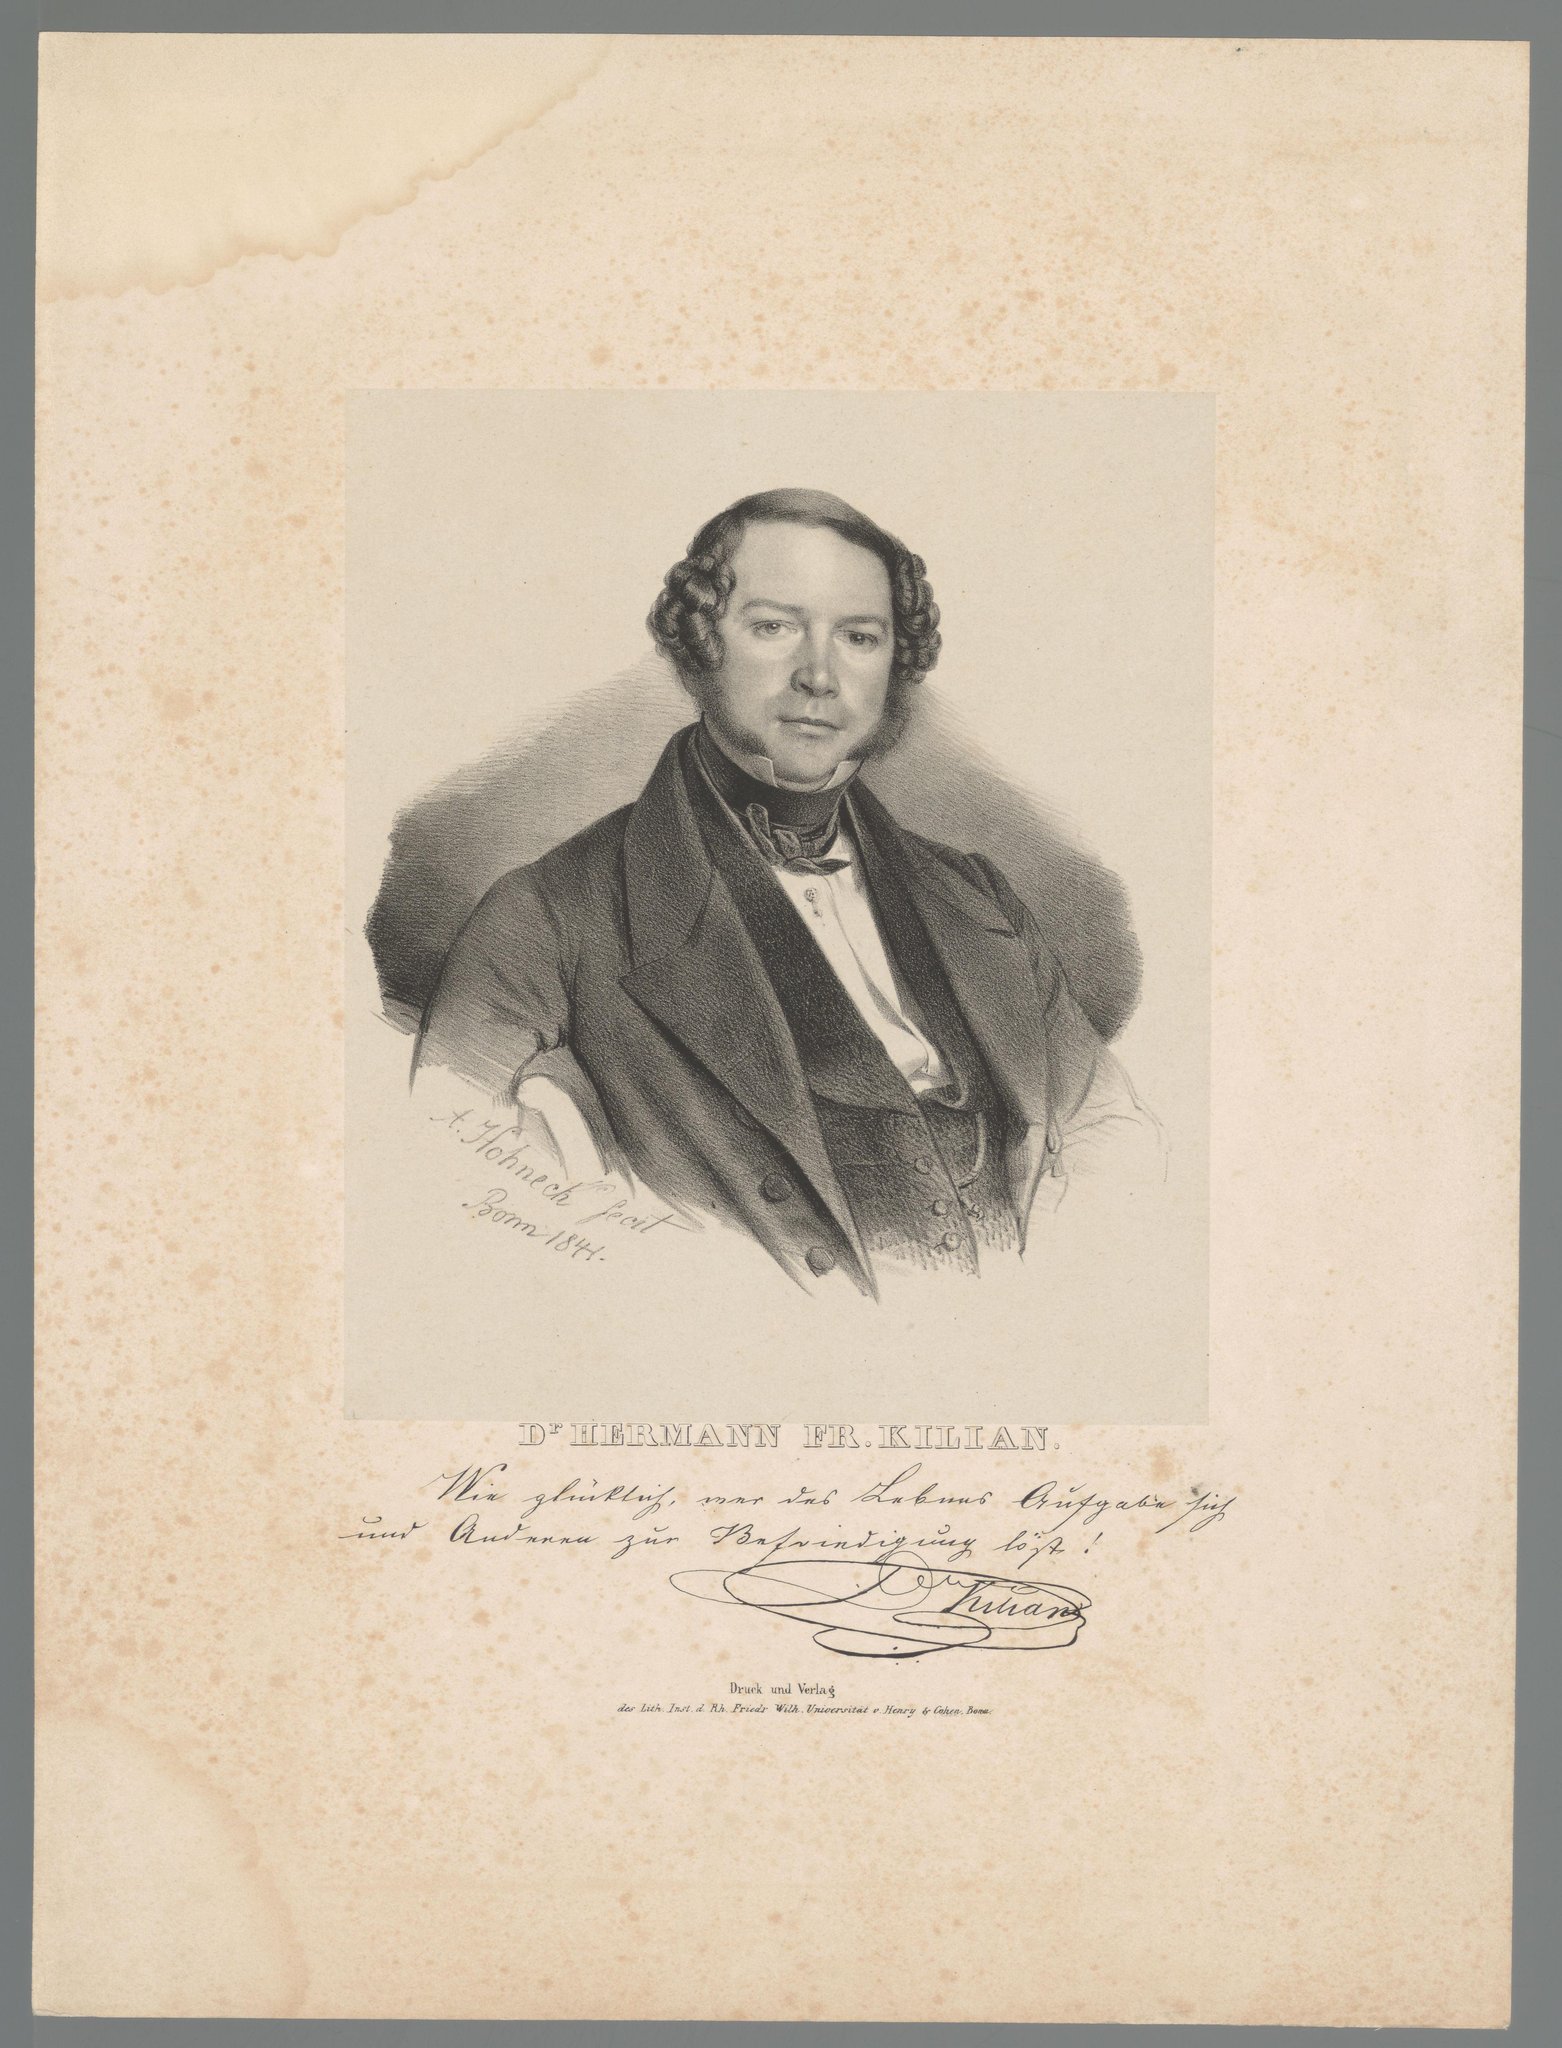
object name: print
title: Portret van Hermann Kilian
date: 1844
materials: paper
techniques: lithograph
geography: bonn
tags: hermann kilian, adult man, historical persons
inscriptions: collector's mark: Lugt 2228